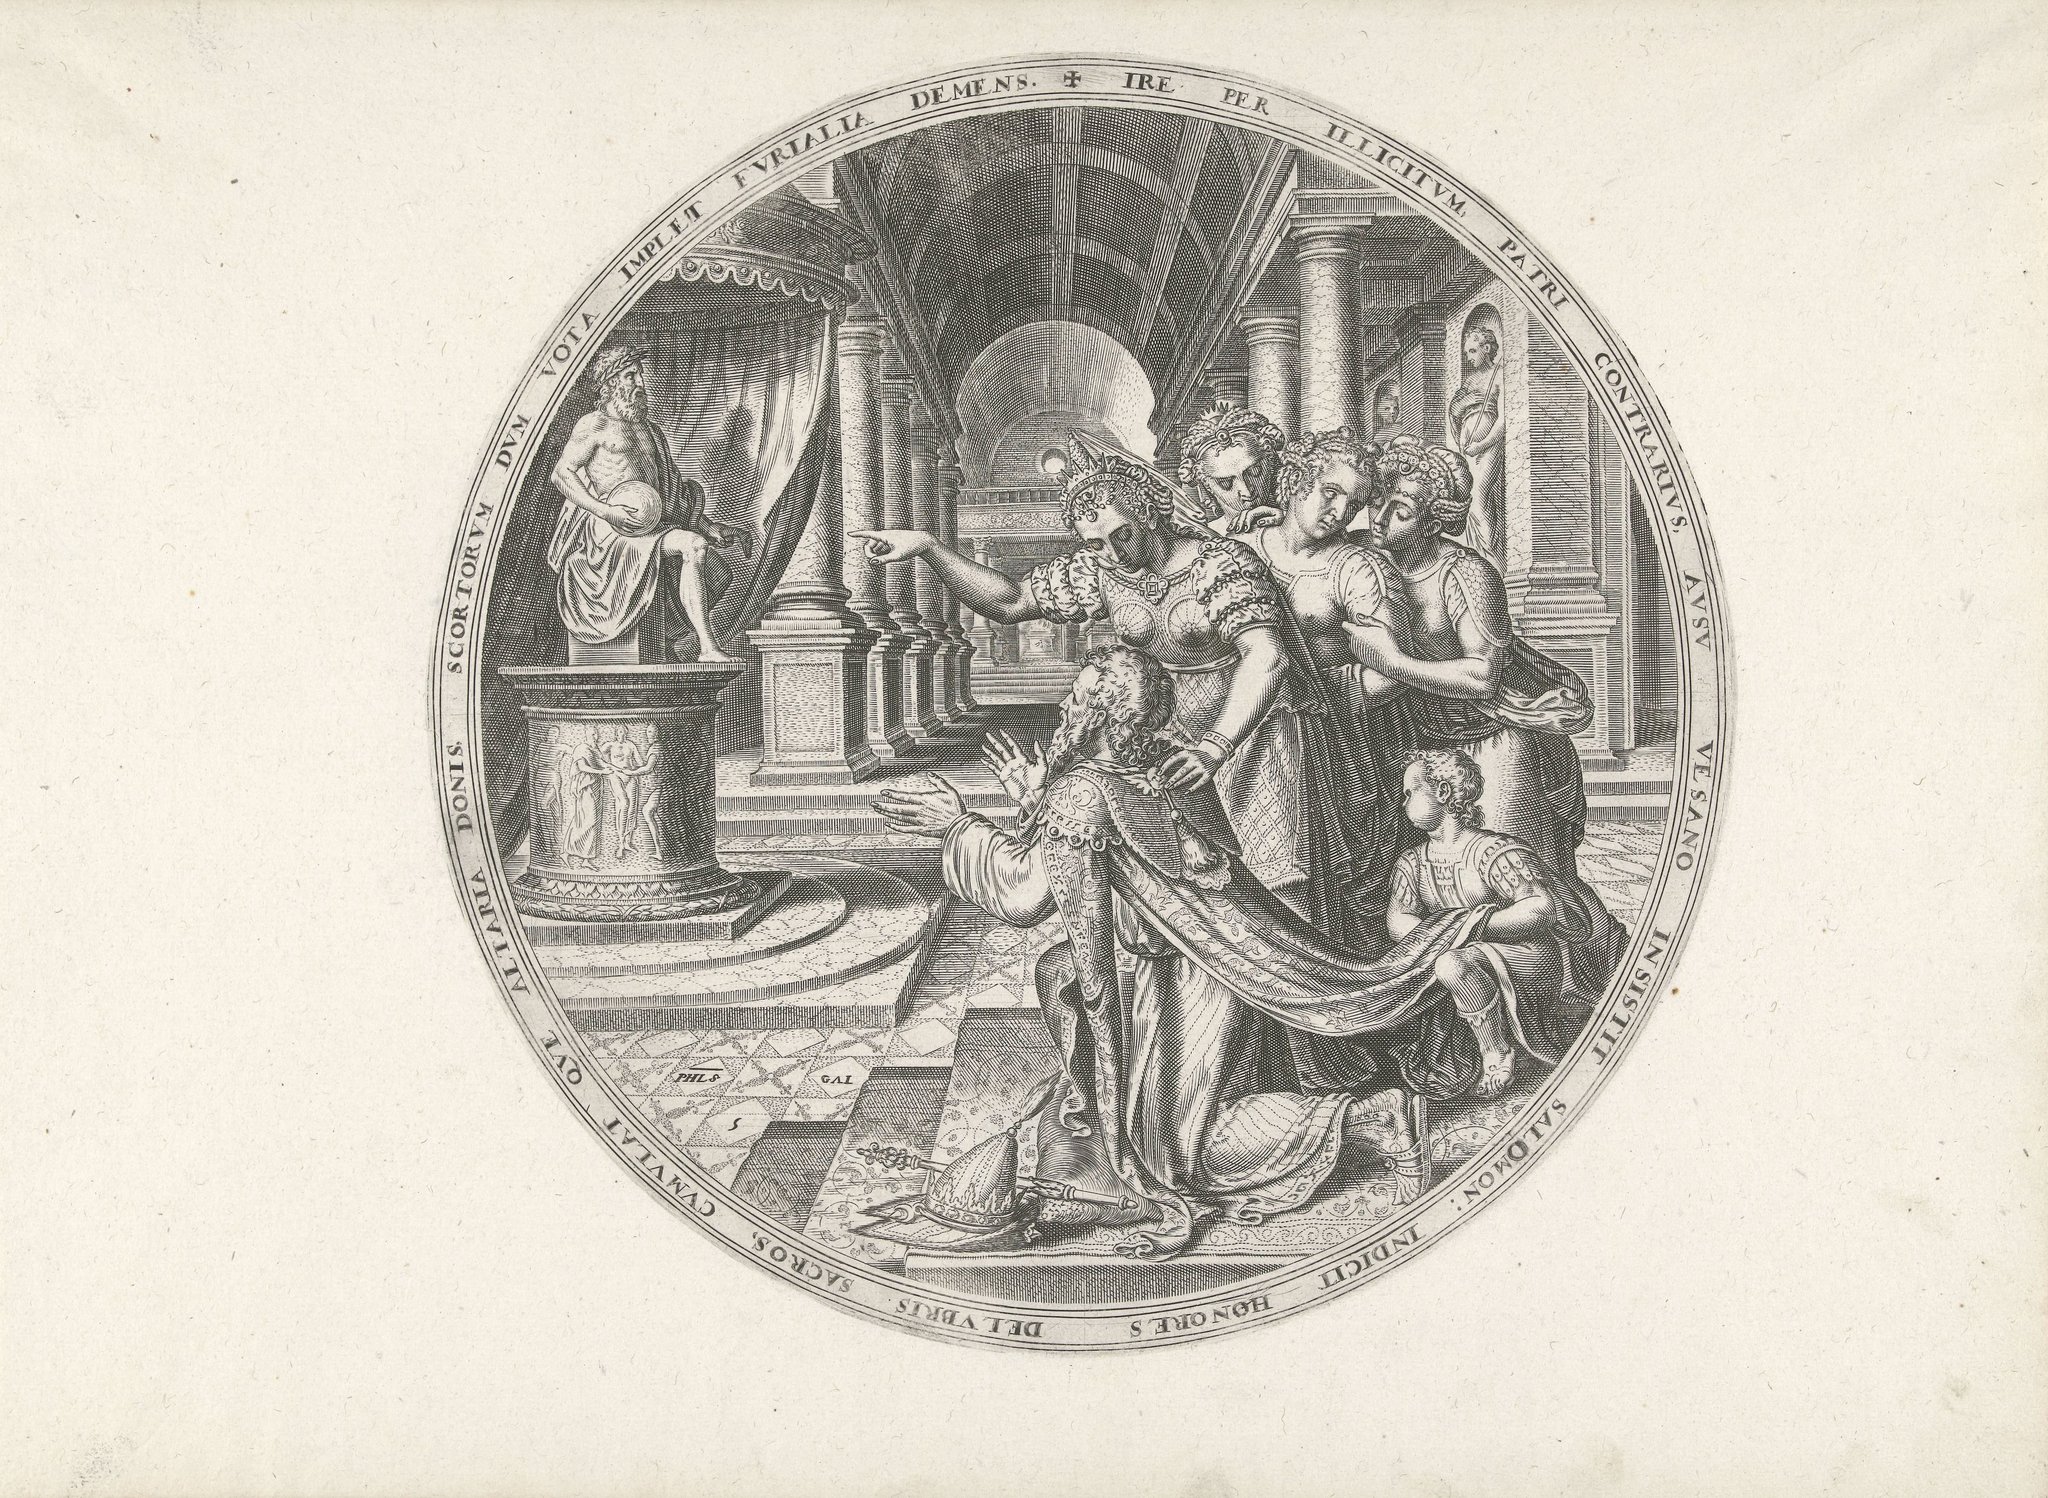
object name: print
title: Salomo's afgoderij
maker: philips galle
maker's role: print maker, publisher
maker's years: 1537-1612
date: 1569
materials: paper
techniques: engraving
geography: haarlem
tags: solomon's idolatry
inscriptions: collector's mark: Lugt 2228, collector's mark: Lugt 2760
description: Salomo vereerd, misleid door zijn geliefde, een beeld van een afgod. In een paleis knielt hij neer voor het beeld van een heidense godheid.